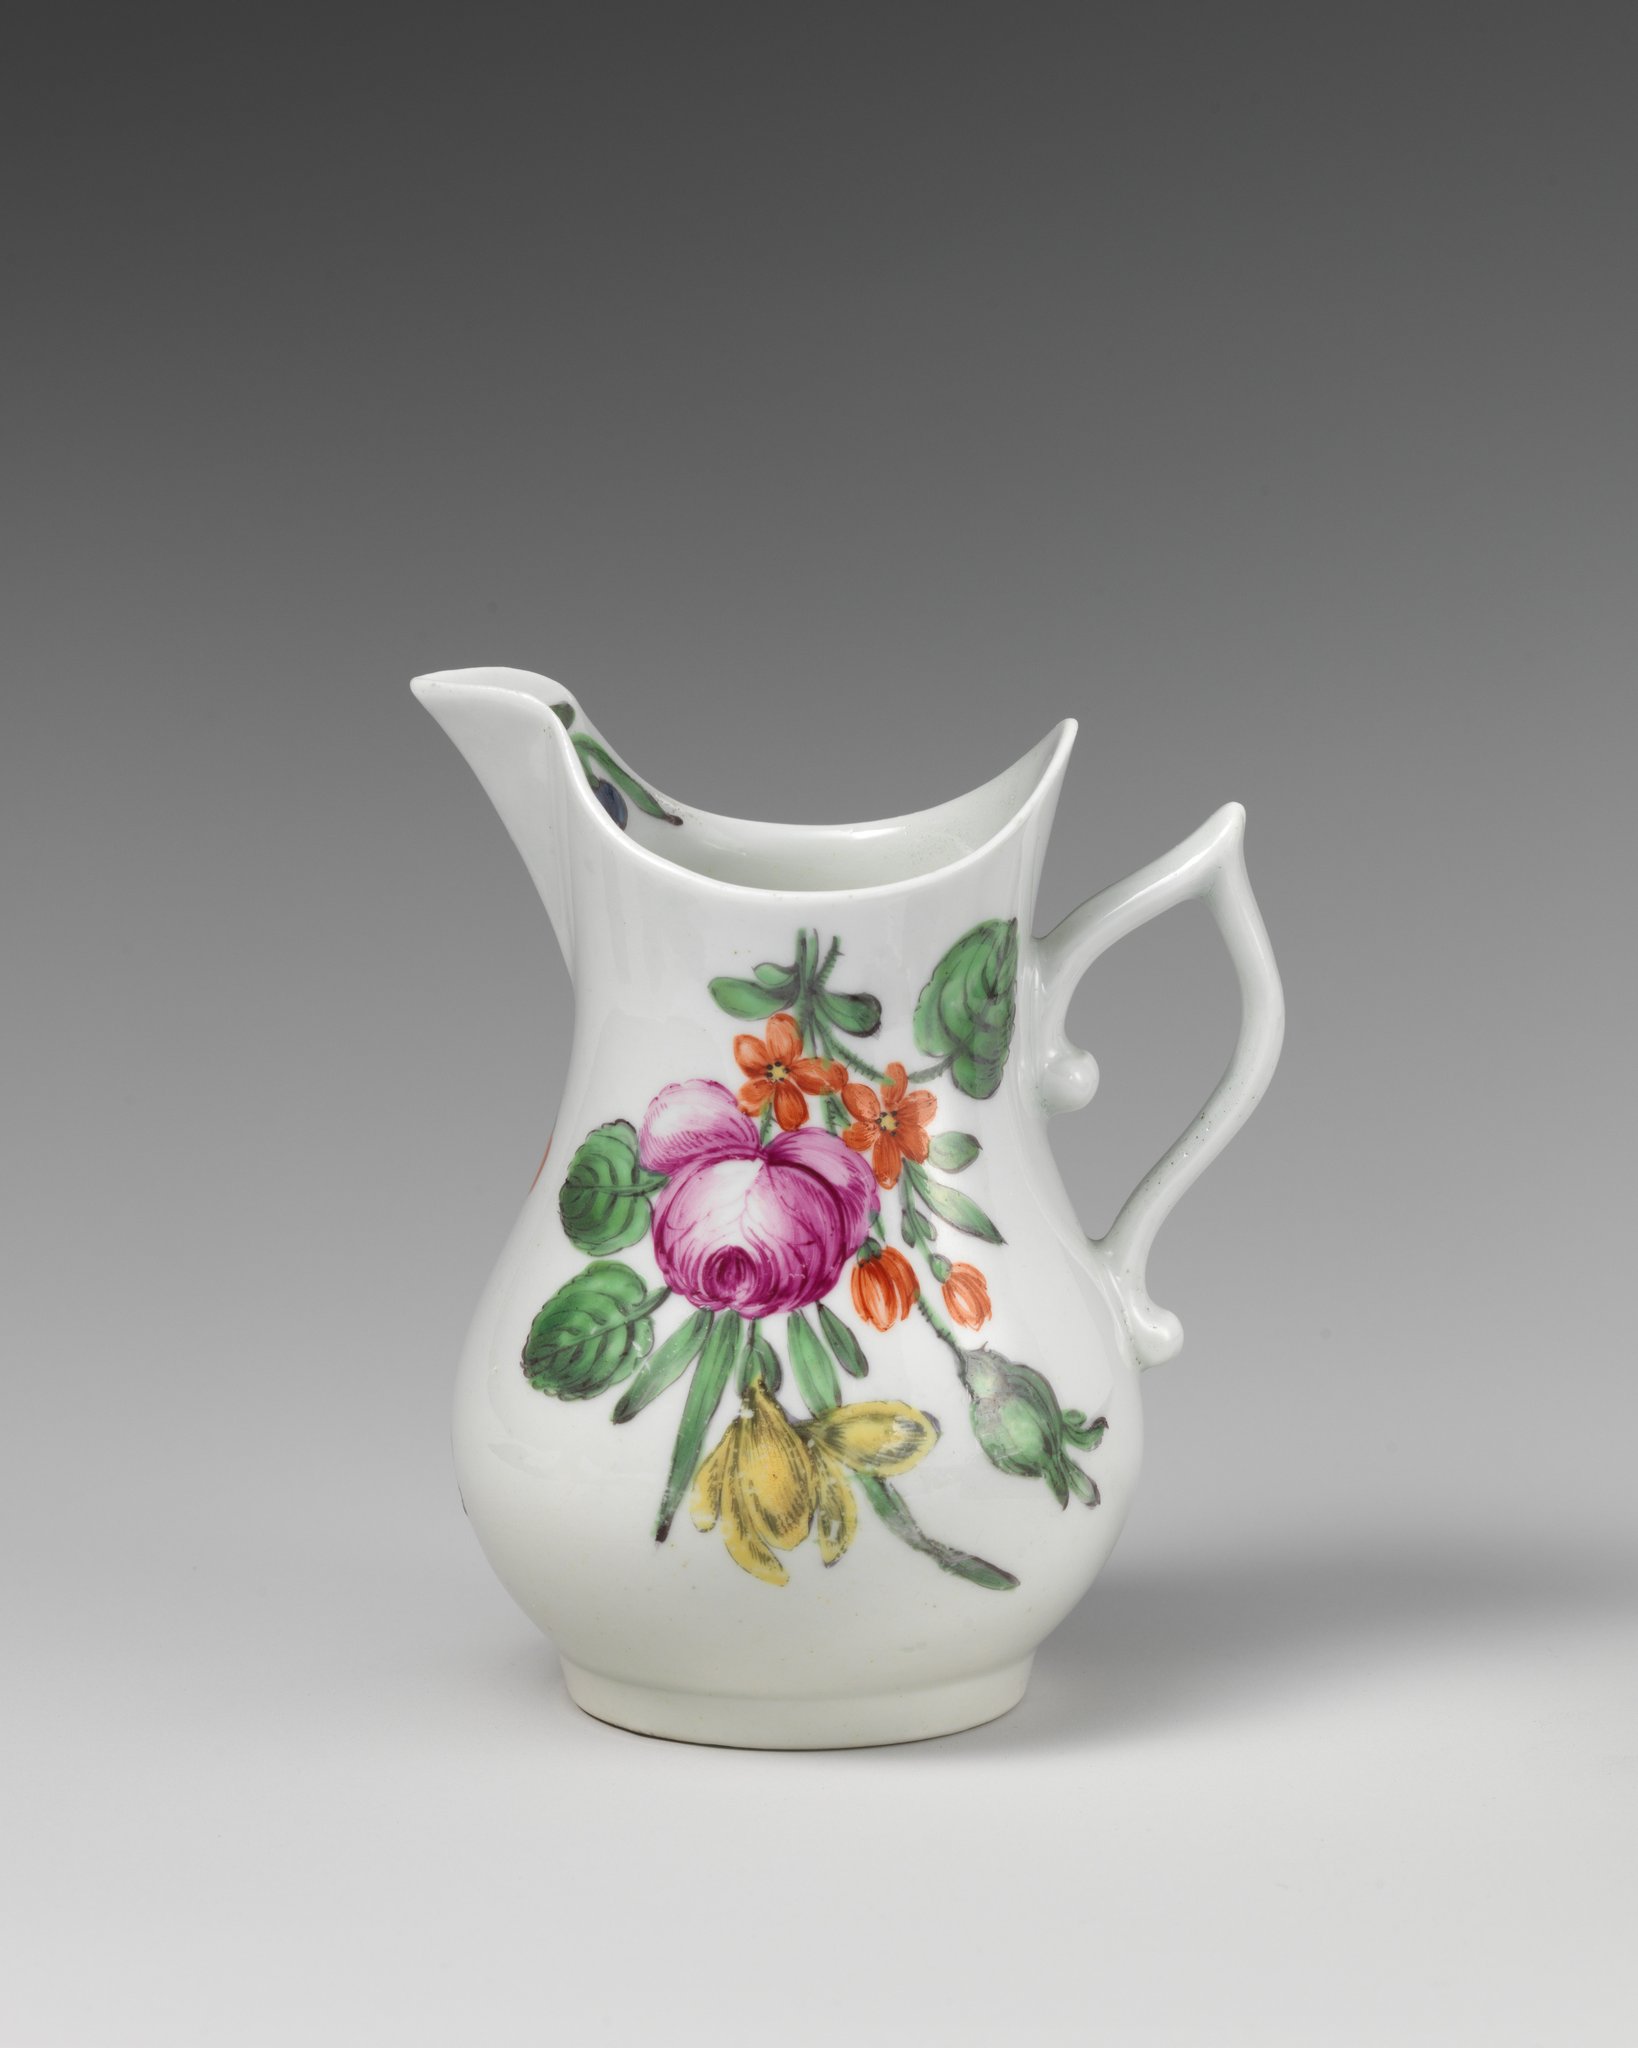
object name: jug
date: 1701-1800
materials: soft paste porcelain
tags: flowers